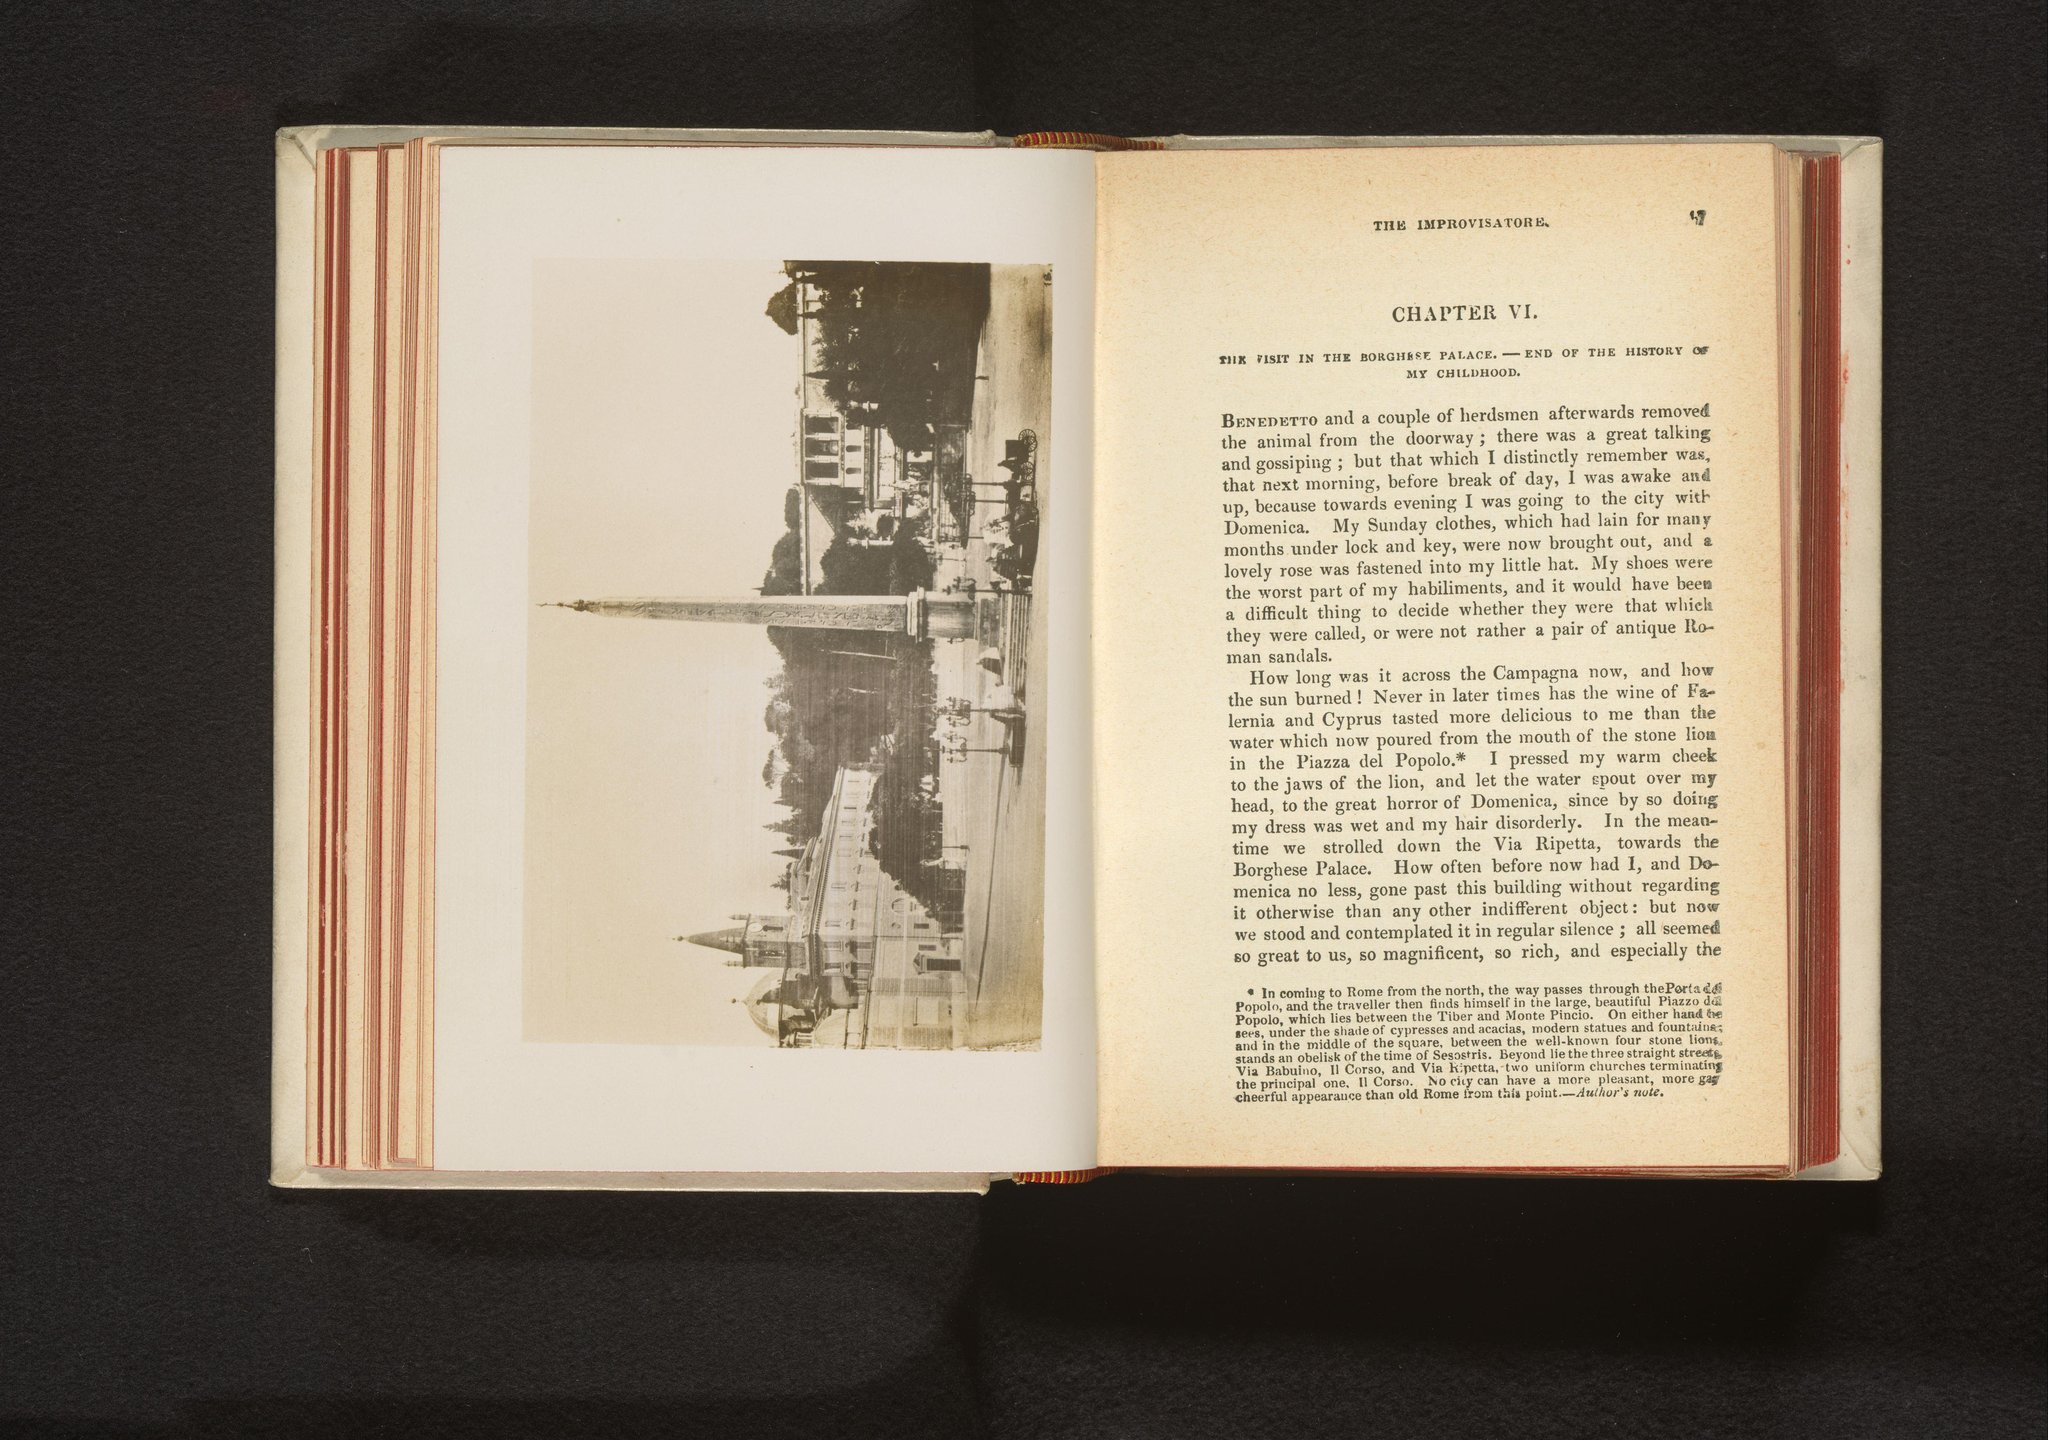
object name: photograph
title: Obelisk op het Piazza del Popolo te Rome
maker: Anonymous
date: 1870-1880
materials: photographic support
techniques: gelatin silver print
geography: piazza del popolo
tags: square, place, circus, etc., obelisk, needle